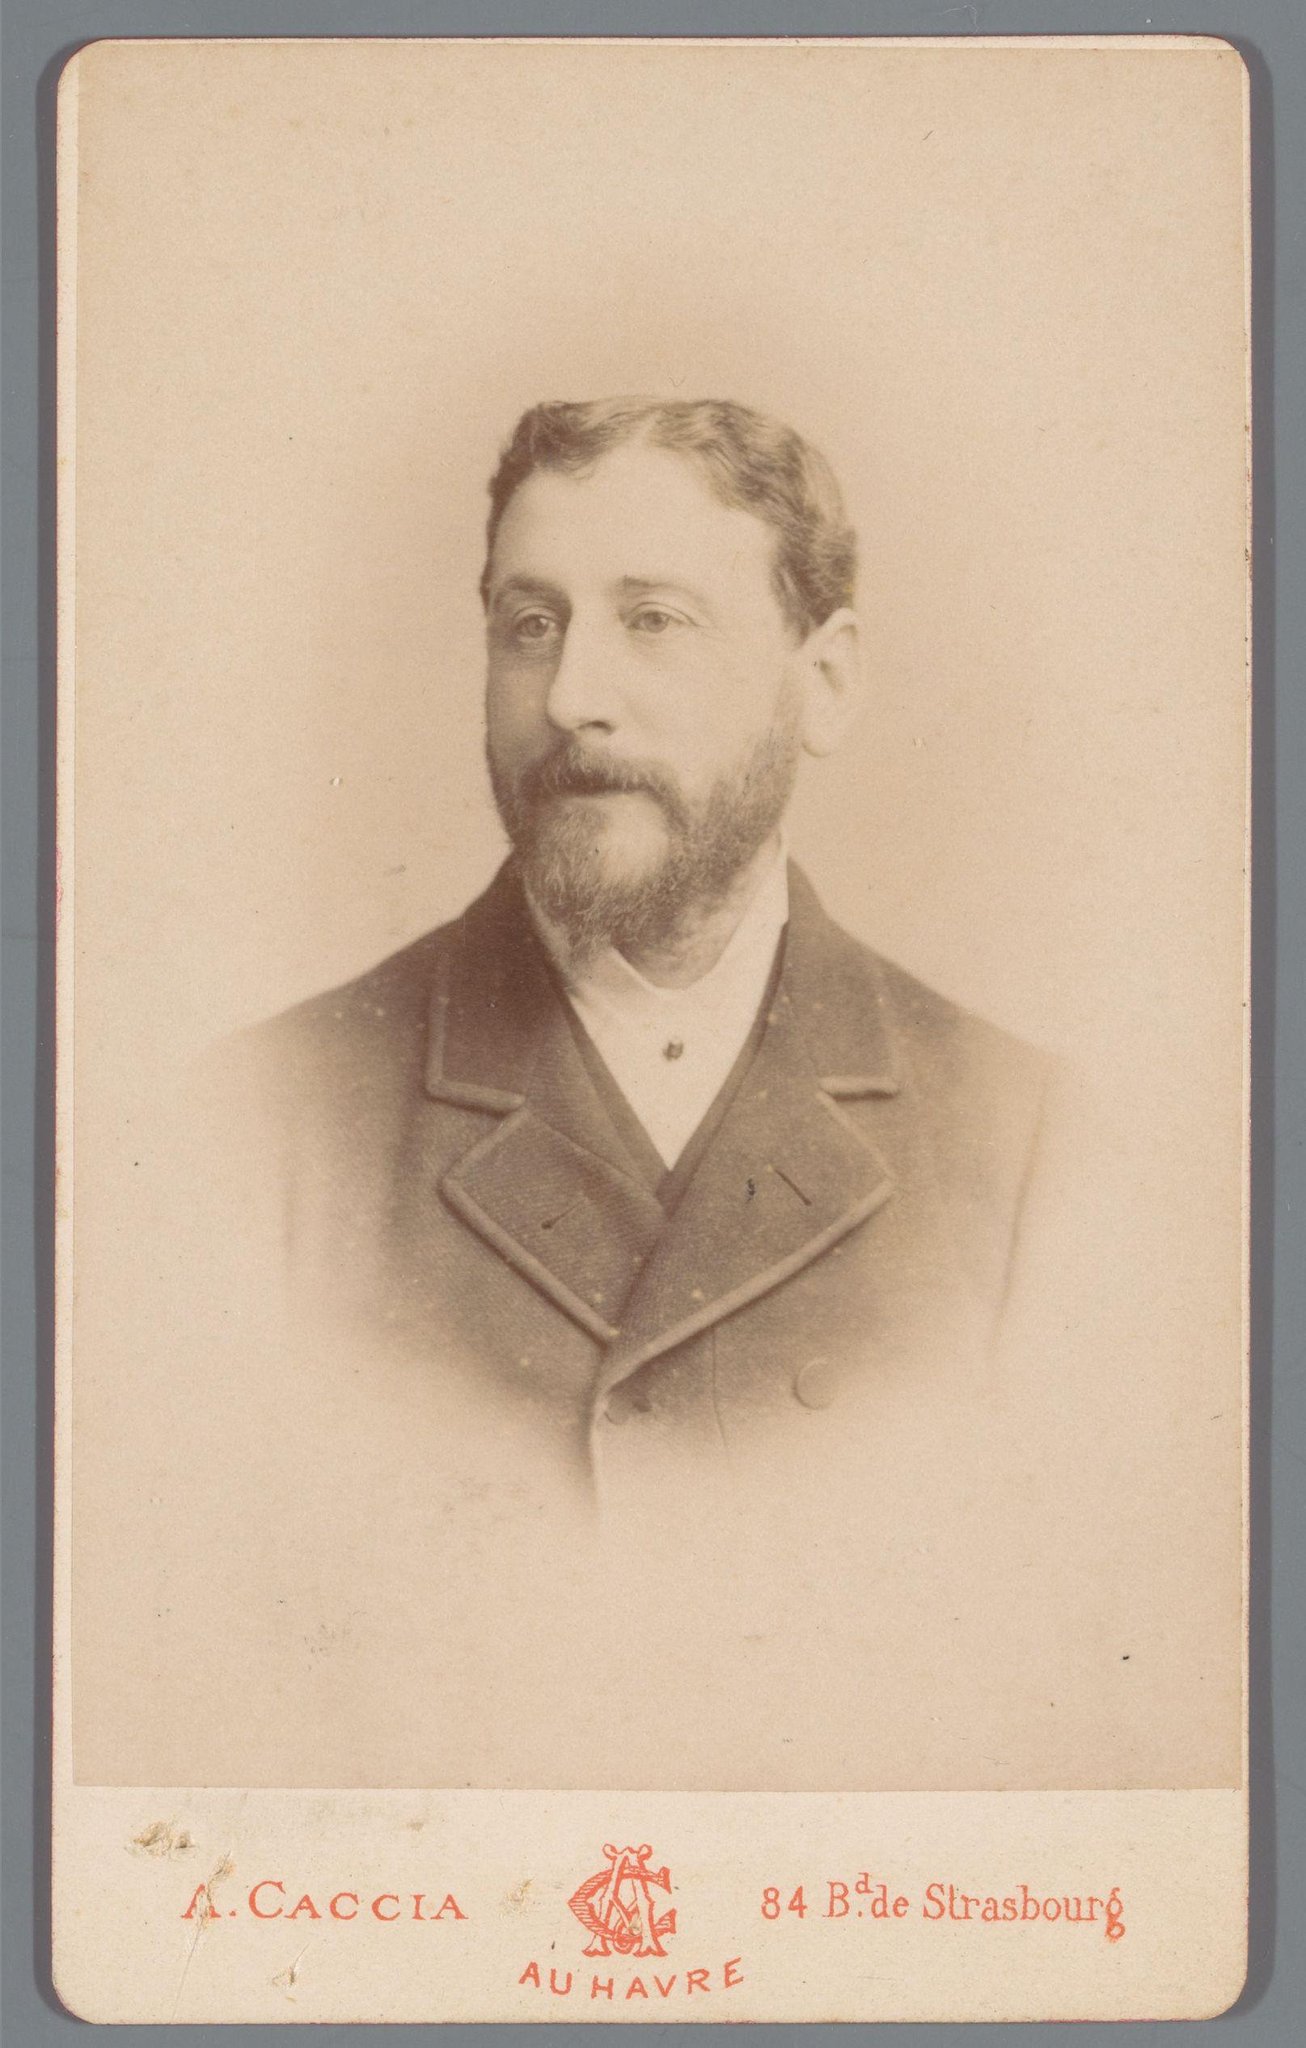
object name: carte de visite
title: Portret van een onbekende man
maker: angelo maria alessio caccia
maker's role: fotograaf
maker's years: 1802-1877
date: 1868-1890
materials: cardboard, paper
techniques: albumen print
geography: le havre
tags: adult man, anonymous historical person portrayed, le havre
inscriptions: monogram: ‘AC’, inscription: ‘Art & Photographie/ A. Caccia/ Havre/ 84/ Boulevard de Strasbourg/ Les Clichés sont conservés/ D. Hutinet - Paris’, inscription: ‘A. Caccia 84 Bd. de Strasbourg/ au Havre’